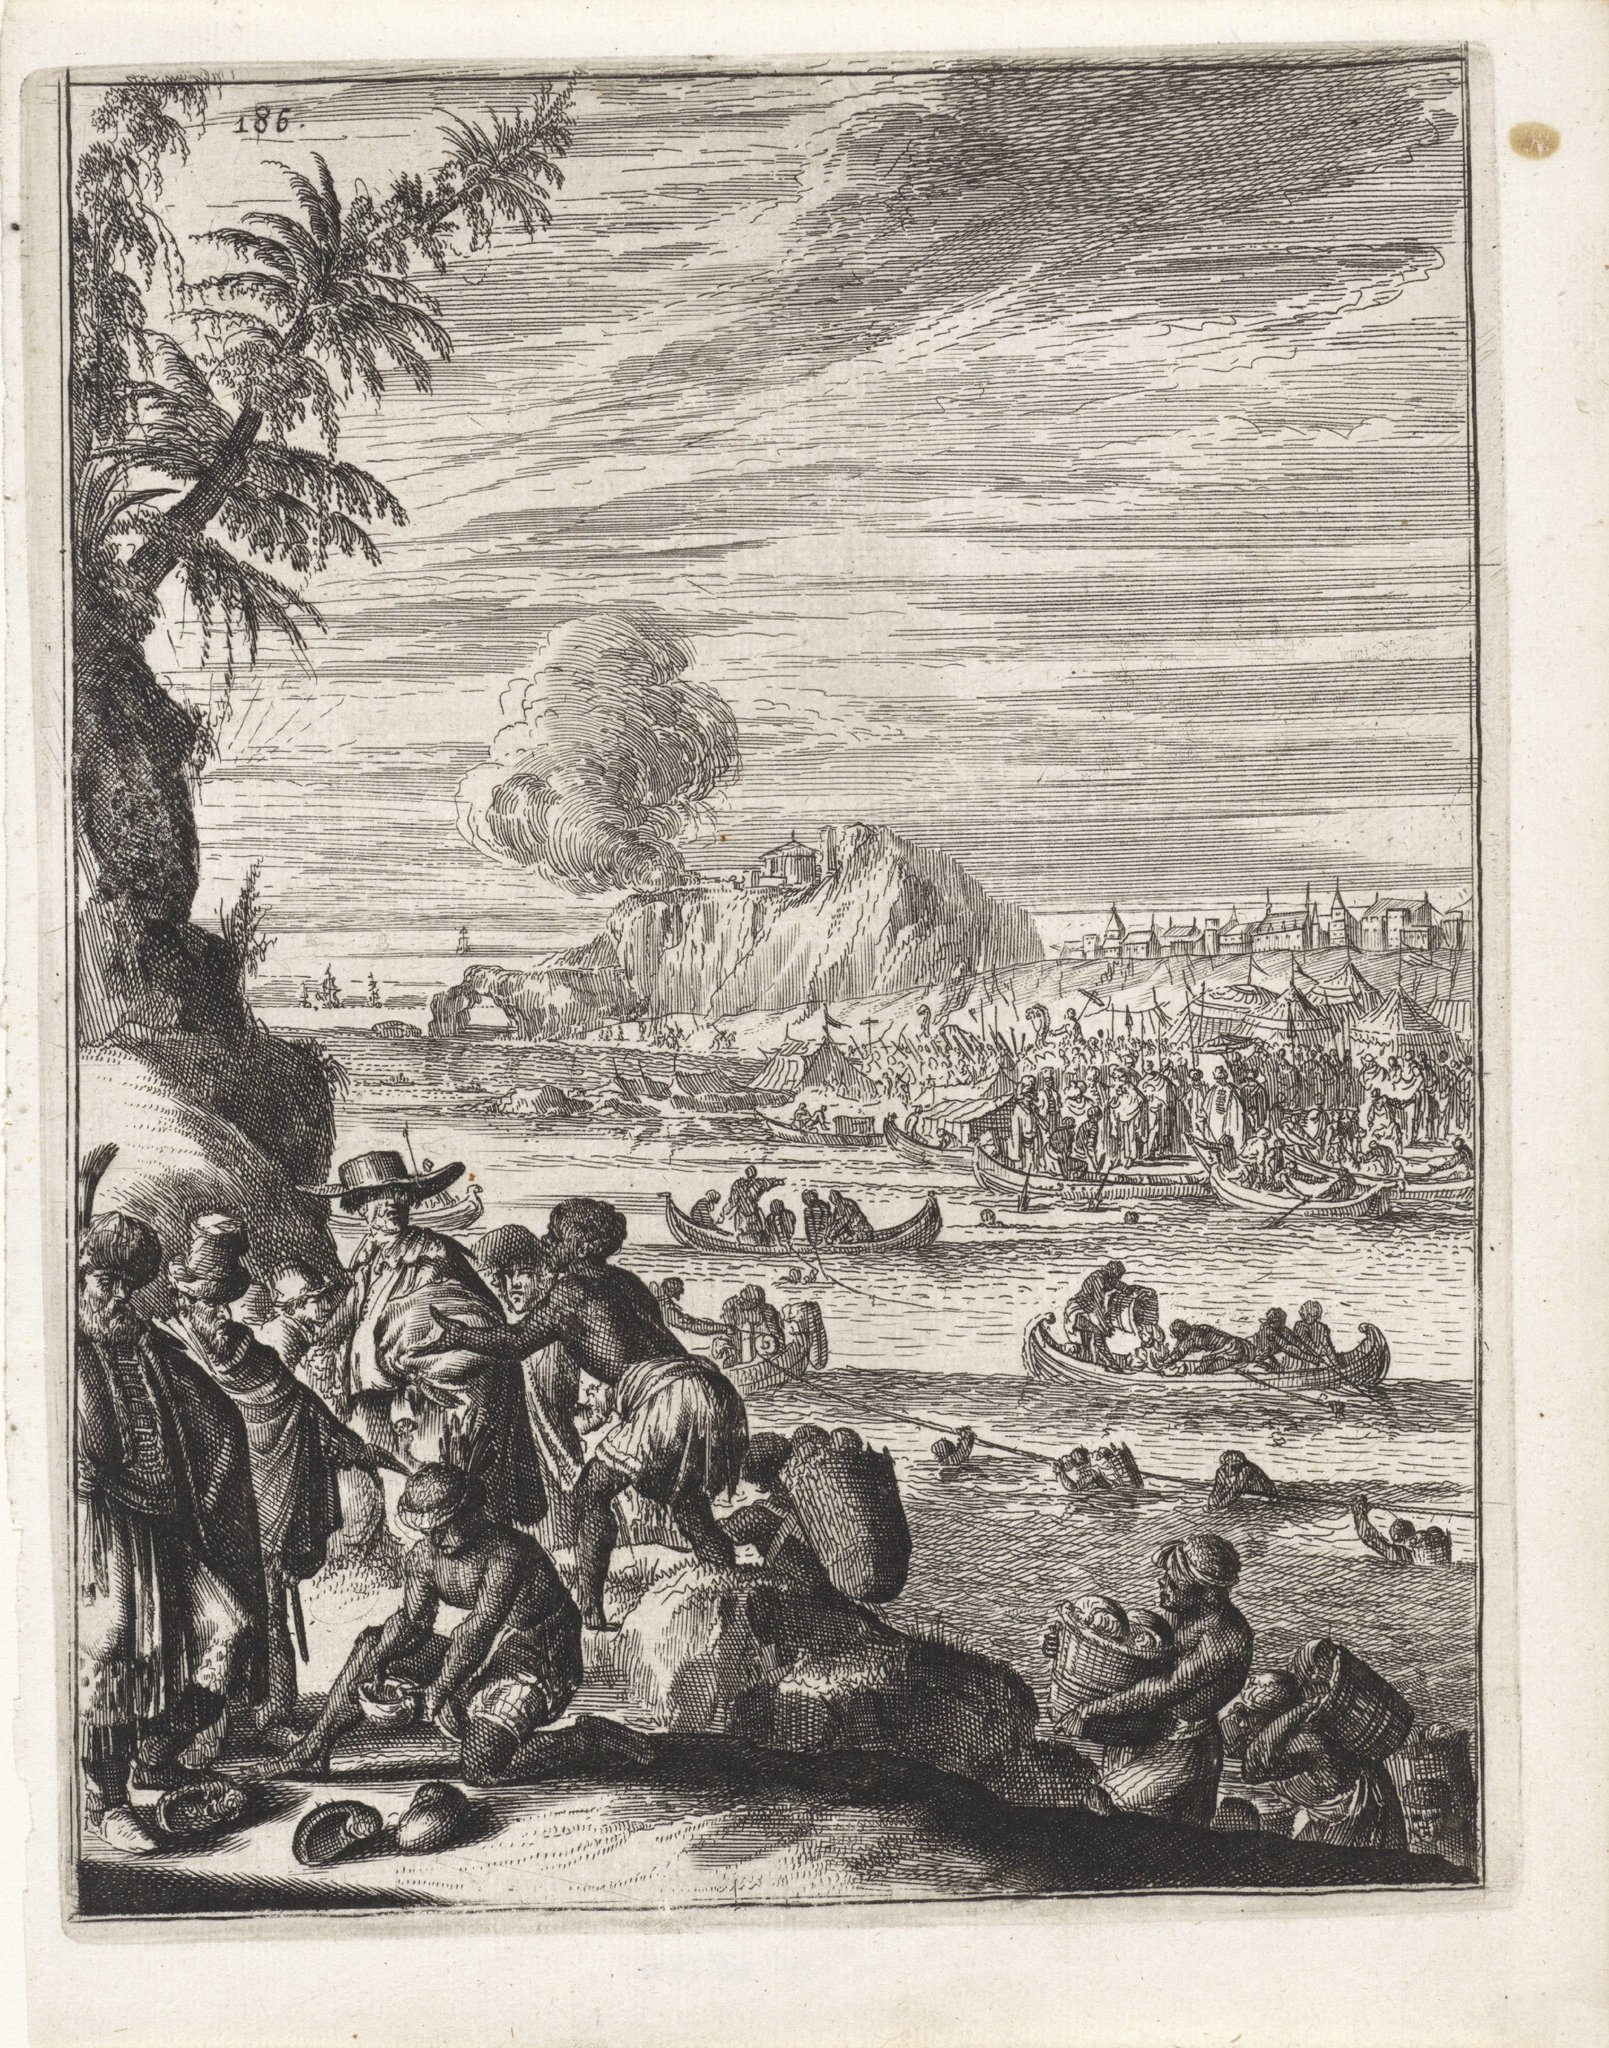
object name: print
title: Parelvissers voor de kust van Tuticorin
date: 1676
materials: paper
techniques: engraving, etching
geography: low countries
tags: traffic and transport, rowing-boat, canoe, etc., asiatic races and peoples: indians, pearl fishing, pearl diving; coral fishing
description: Aan de kust van Tuticorin (Thoothukudi) in India brengen parelvissers via lijnen in het water manden met oesters naar roeiboten en vervolgens aan land. Aan wal staan Europeanen en een man met een tulband. Linksboven: 186.